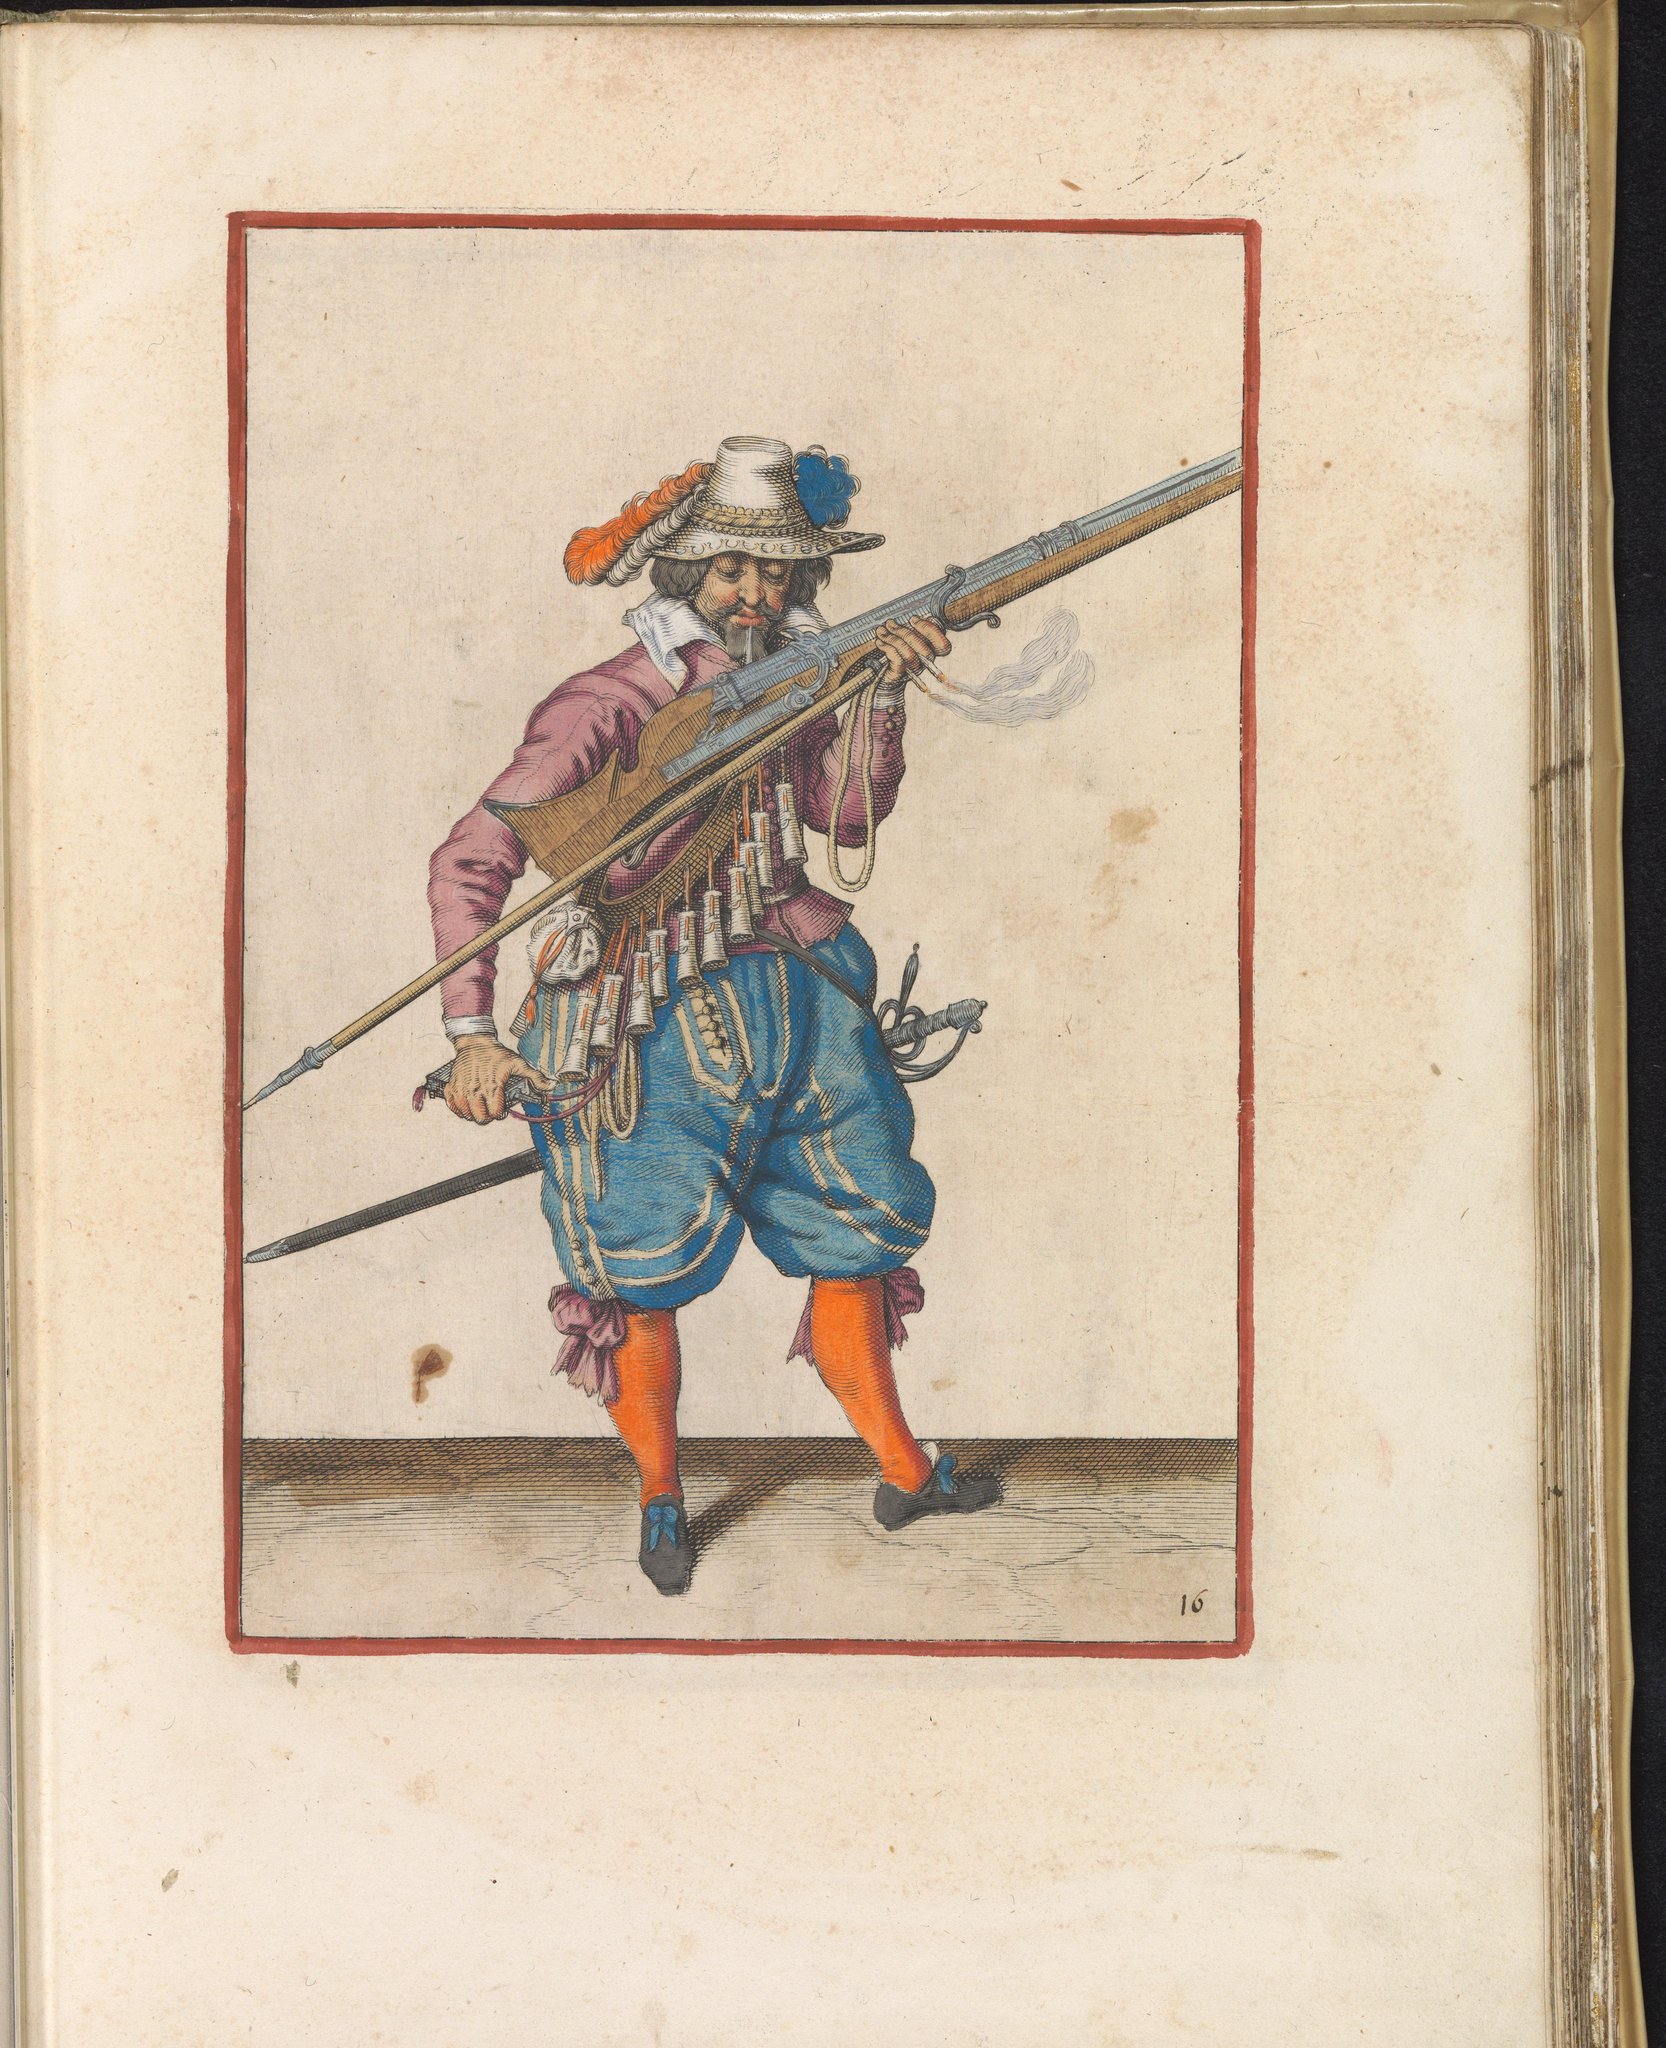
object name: print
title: Soldaat die vonken wegblaast van de pan van zijn musket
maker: jacques de gheyn (ii)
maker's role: painter, print maker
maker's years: 1565-1629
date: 1597-1607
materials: paper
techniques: engraving, hand coloring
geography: the hague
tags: handling of weapons ~ military training, firearms: rifle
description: Een soldaat, ten voeten uit, naar rechts, die een musket (een bepaald type vuurwapen) bij zijn mond houdt en over de pan (het kruitreservoir) blaast. In zijn linkerhand behalve het musket ook een furket (musketvork) en een brandende lont. In zijn rechterhand een kruitfles. Deze prent is onderdeel van de reeks van 43 met de hand genummerde prenten van musketiers in de Wapenhandelinghe.